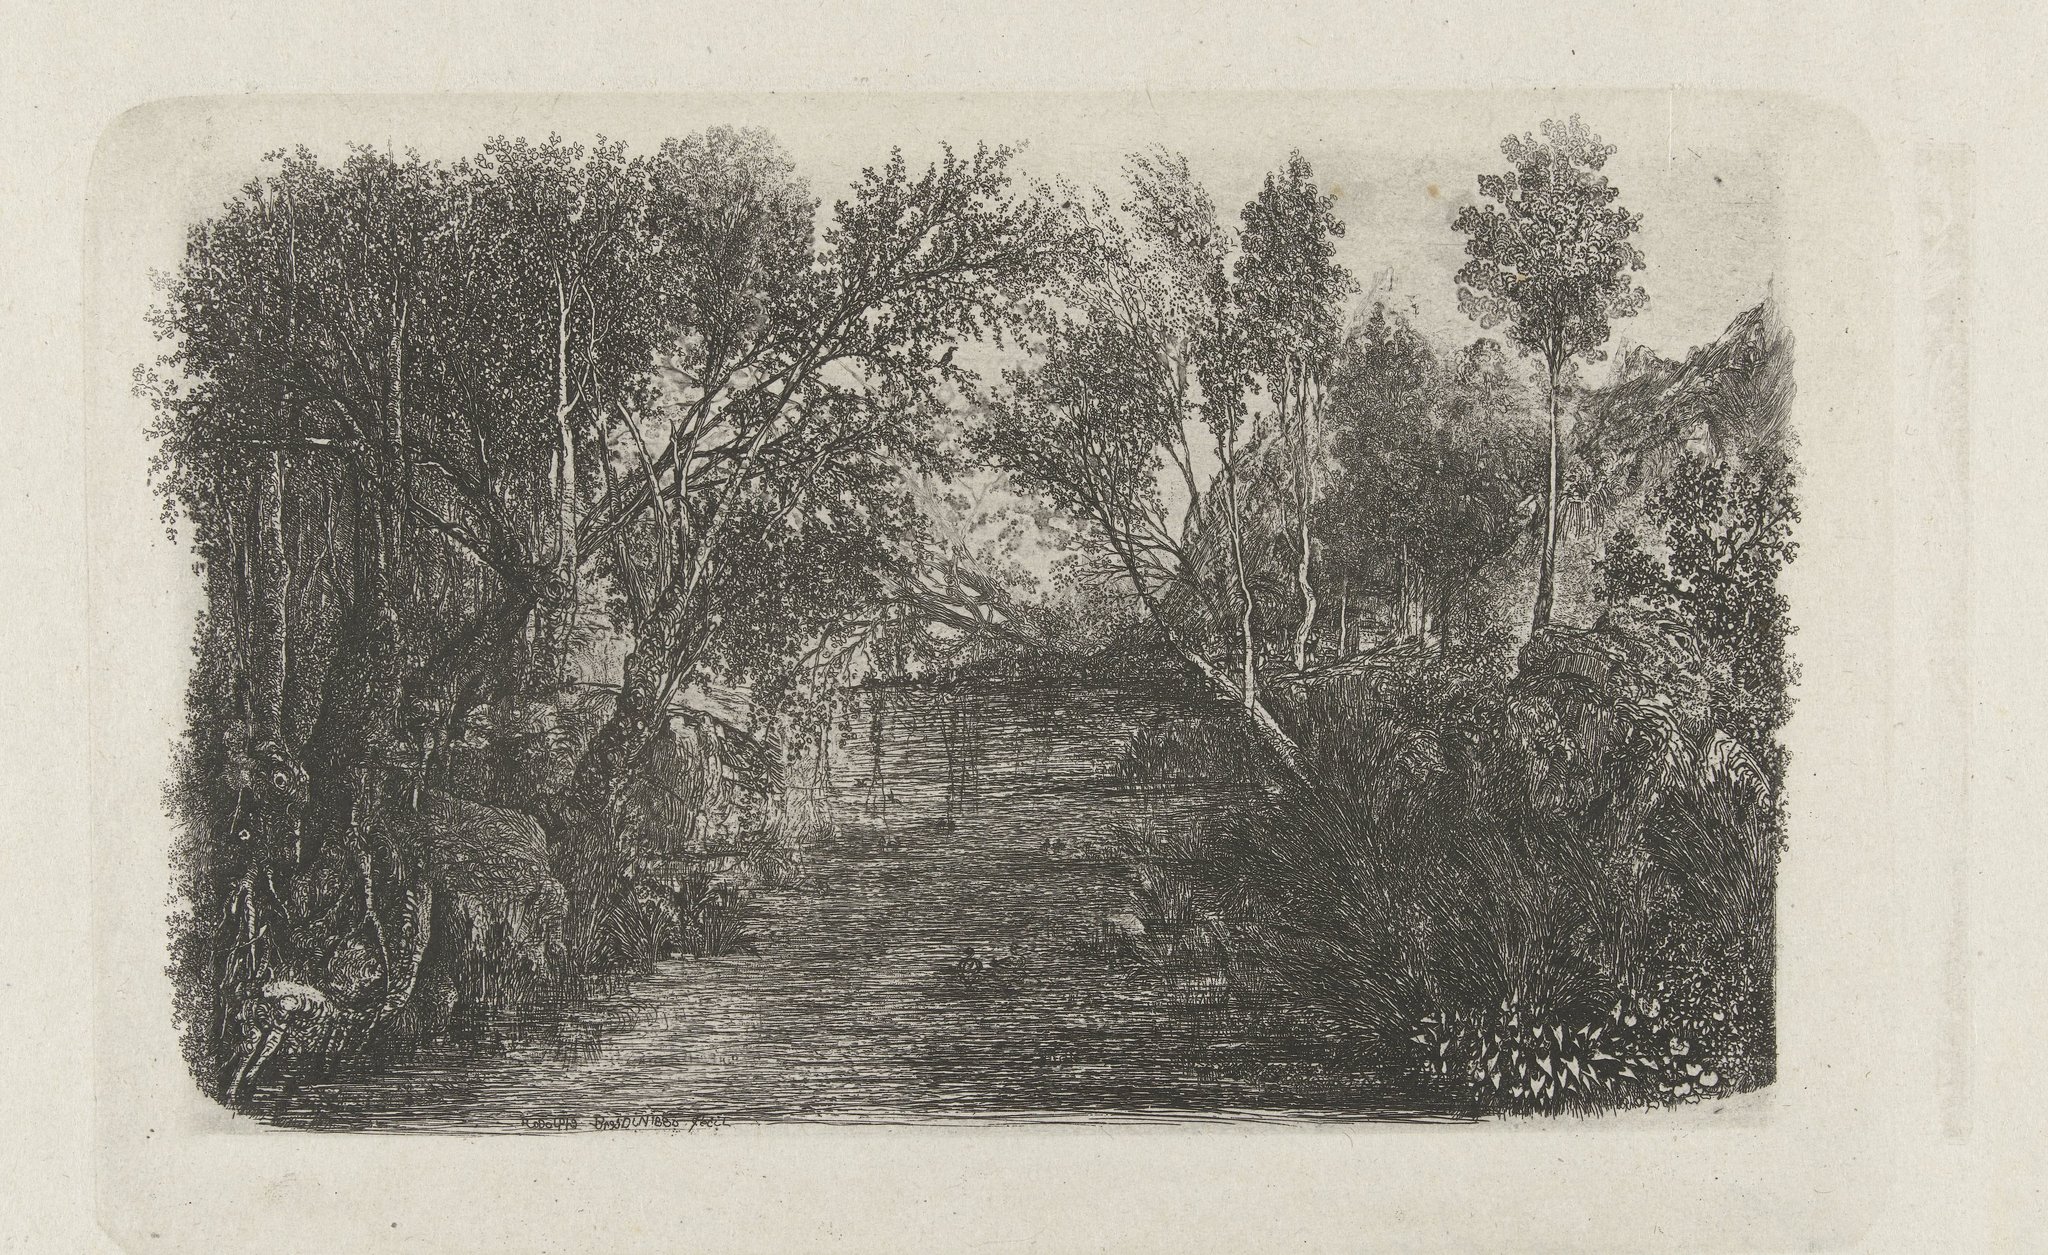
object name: print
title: Le cours d'eau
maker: rodolphe bresdin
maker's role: draughtsman, print maker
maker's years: 1822-1885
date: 1880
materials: paper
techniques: etching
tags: water course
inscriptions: date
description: In tegenstelling tot de andere twee afdrukken van de etsplaat in de collectie van het RMA staat de boomtop van de boom rechts volledig op deze prent (vergelijk RP-P-1949-269 en RP-P-1948-93).